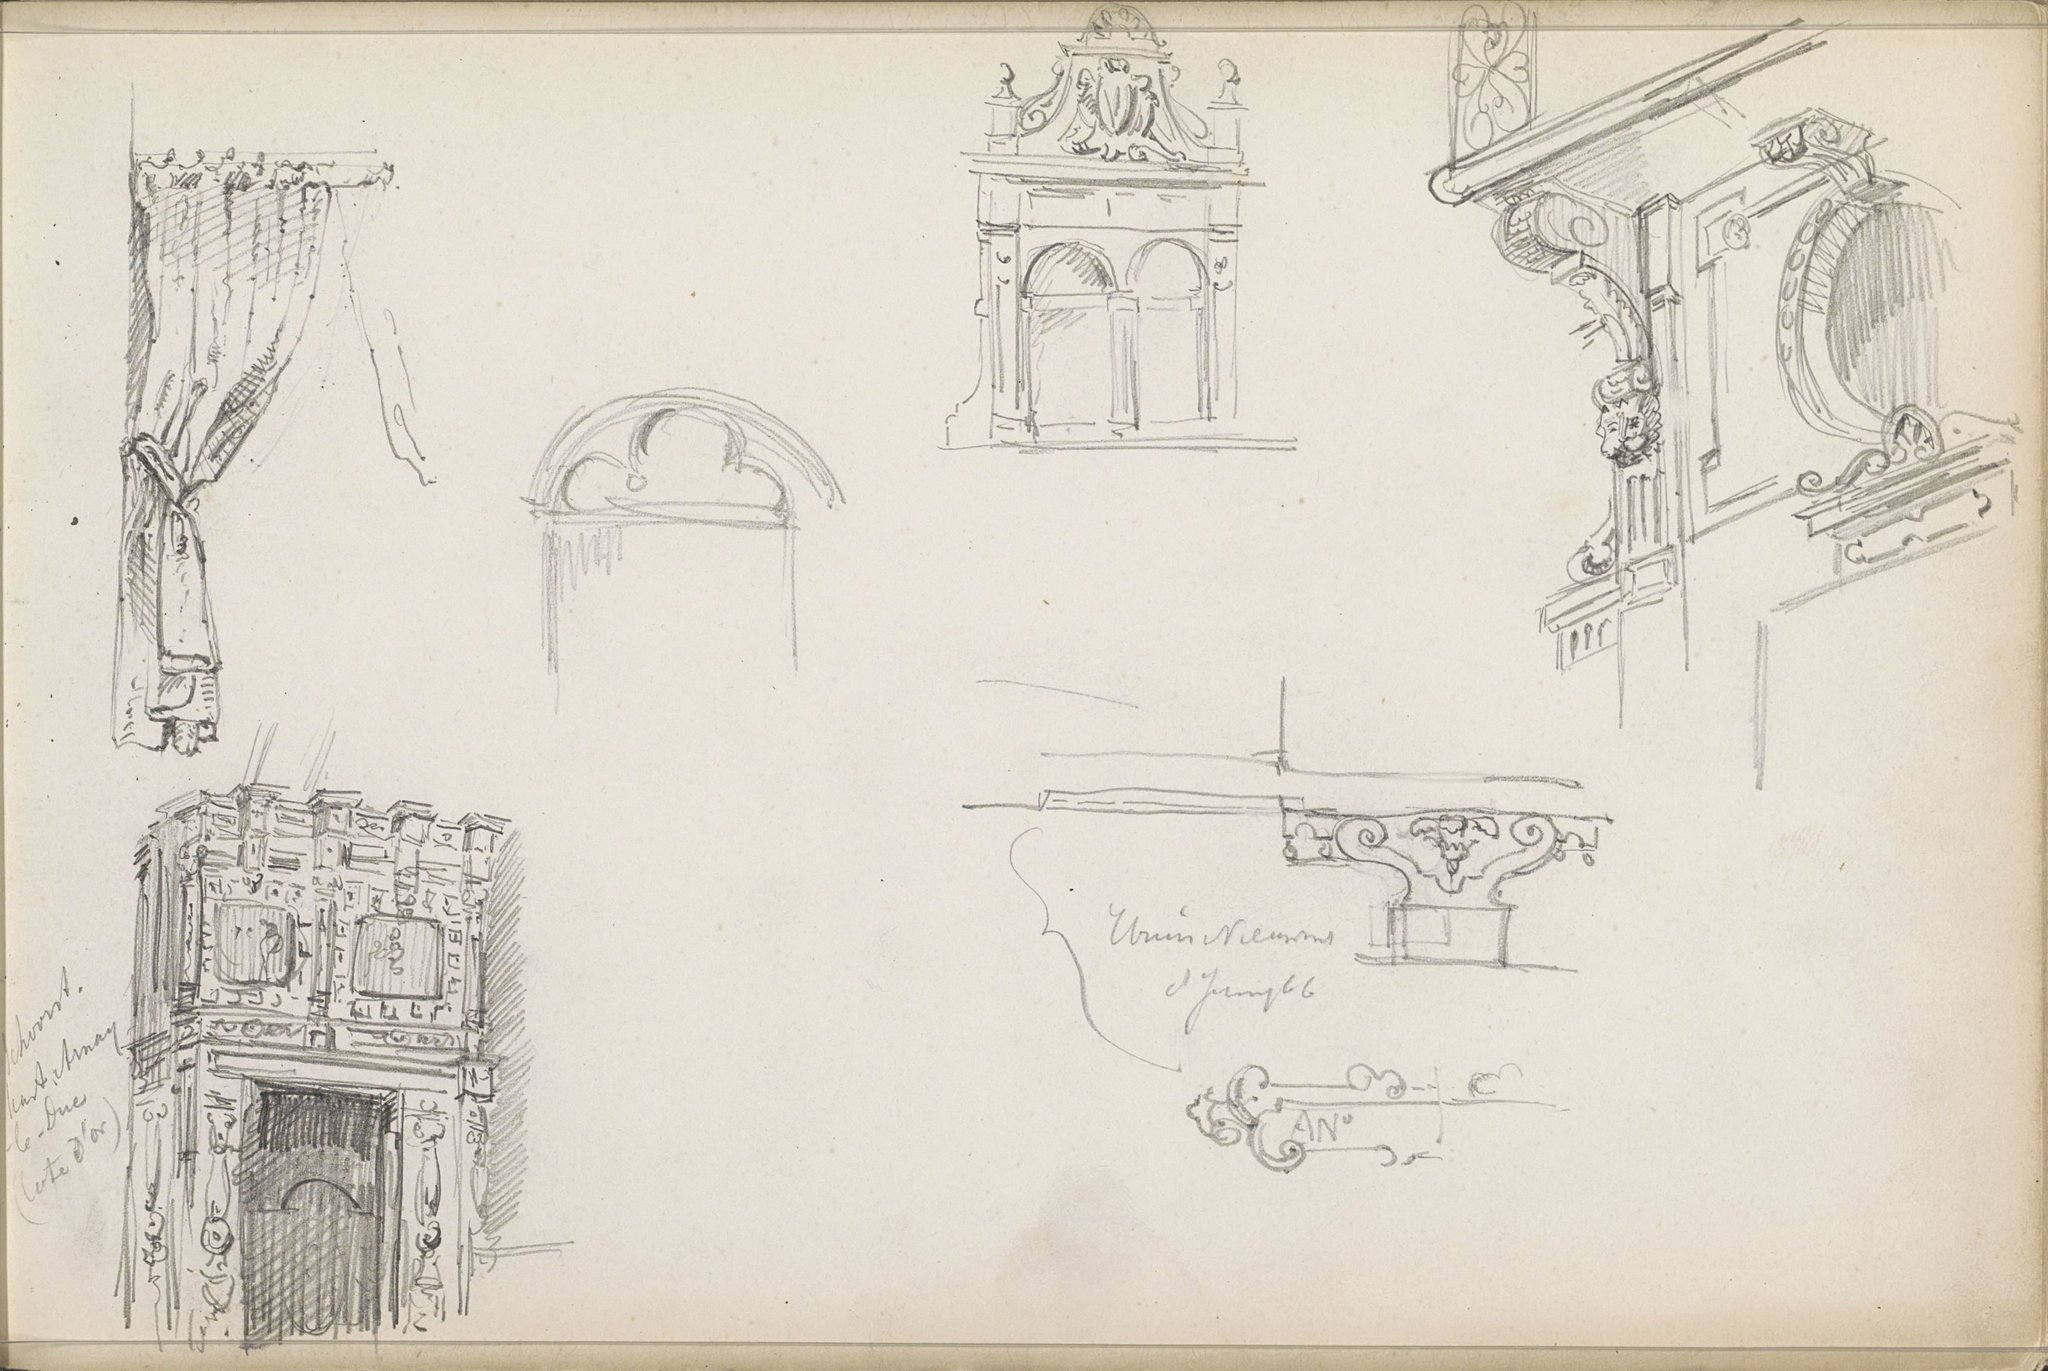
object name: sketchbook leaf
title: Schoorsteenmantel van Kasteel Arnay-le-Duc in Côte-d'Or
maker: isaac gosschalk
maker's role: draughtsman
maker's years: 1838-1907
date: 1806-1866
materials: paper, pencil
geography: arnay-le-duc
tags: curtains, architectural detail, chimney-piece, mantelpiece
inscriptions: date and inscription: ‘schoorst/ kast. Arnay/ -le-Duc/ (Cote d'or)/ [...]/ 8 Juny 66’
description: Tevens studies van een gordijn, venster en een geveltop. Blad 41 recto uit een schetsboek met 58 bladen.